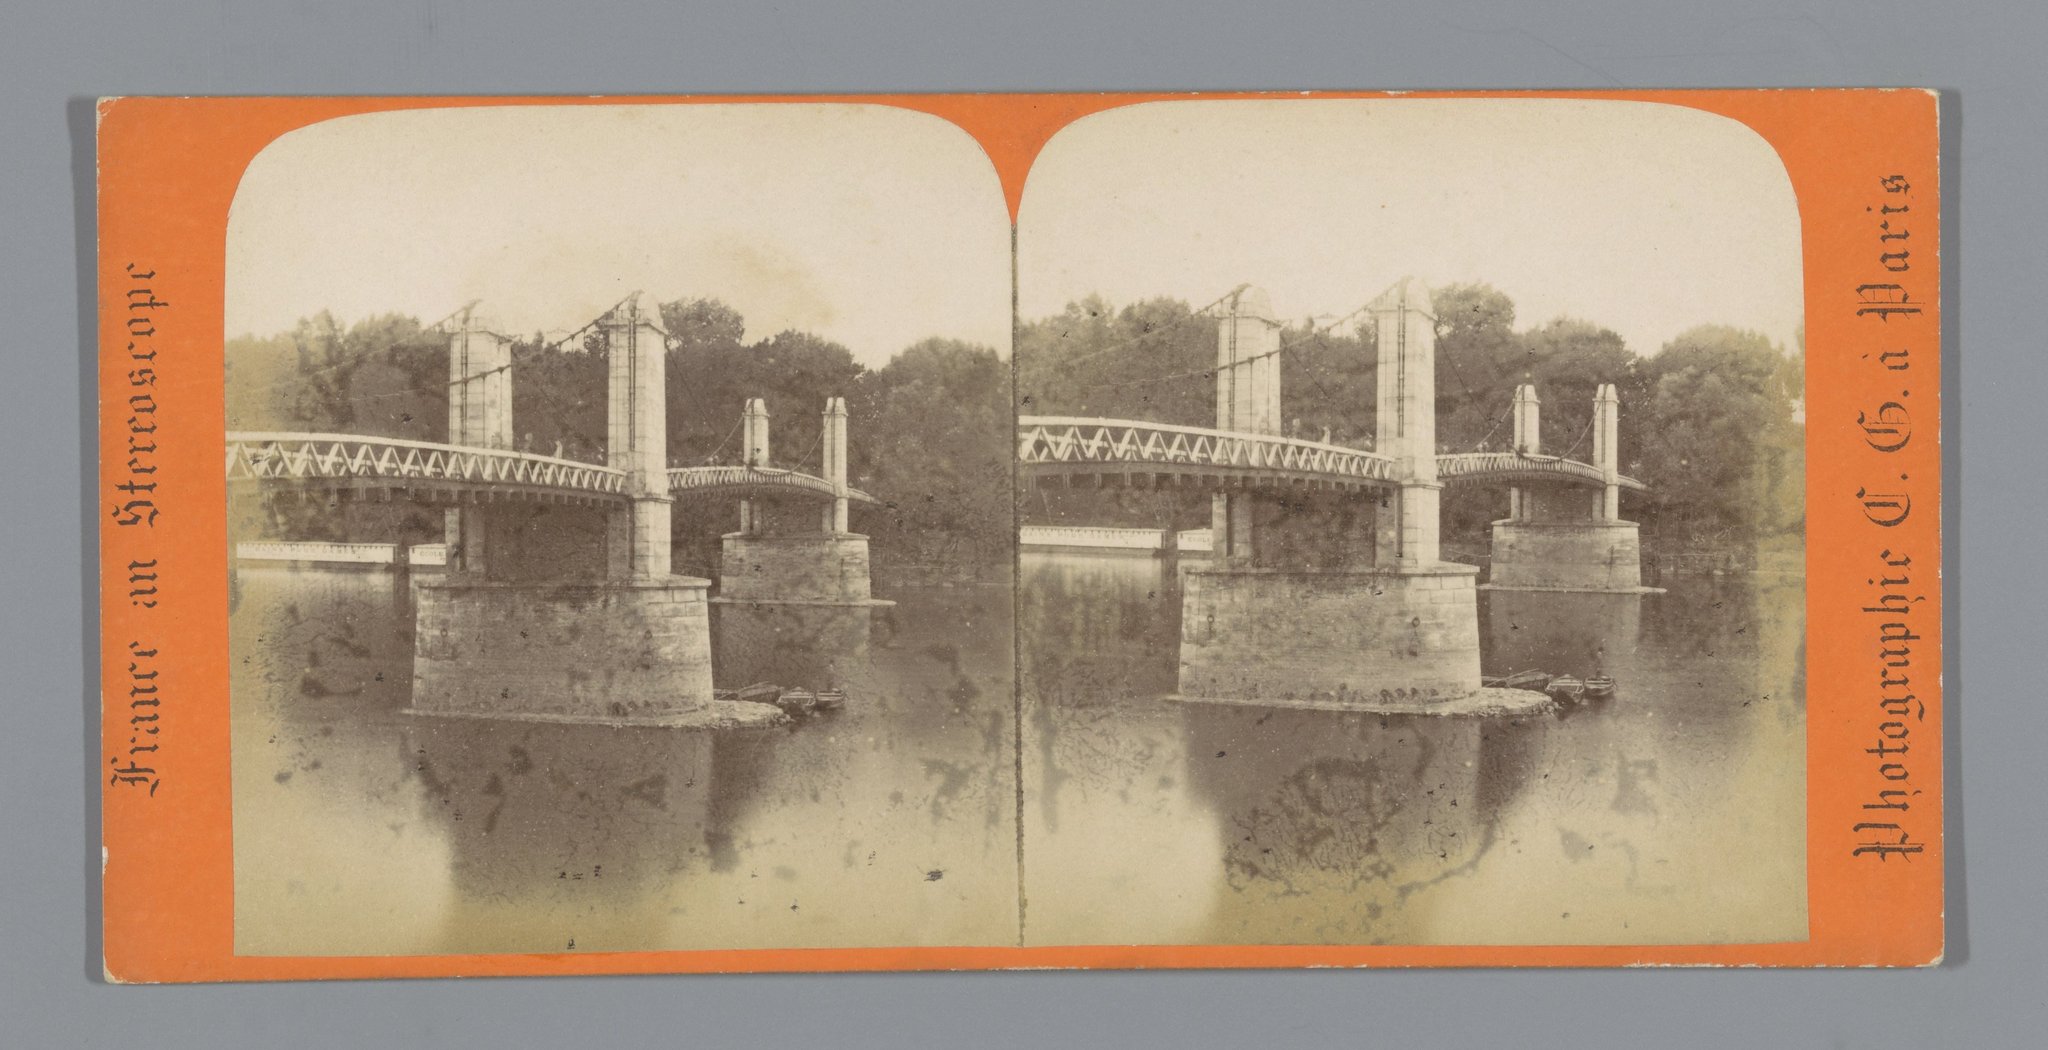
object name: stereograph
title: France au Stereoscope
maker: charles gérard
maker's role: fotograaf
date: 1850-1875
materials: cardboard, photographic support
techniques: albumen print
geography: paris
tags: bridge, paris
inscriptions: inscription: ‘Pont de Turesne Paris’